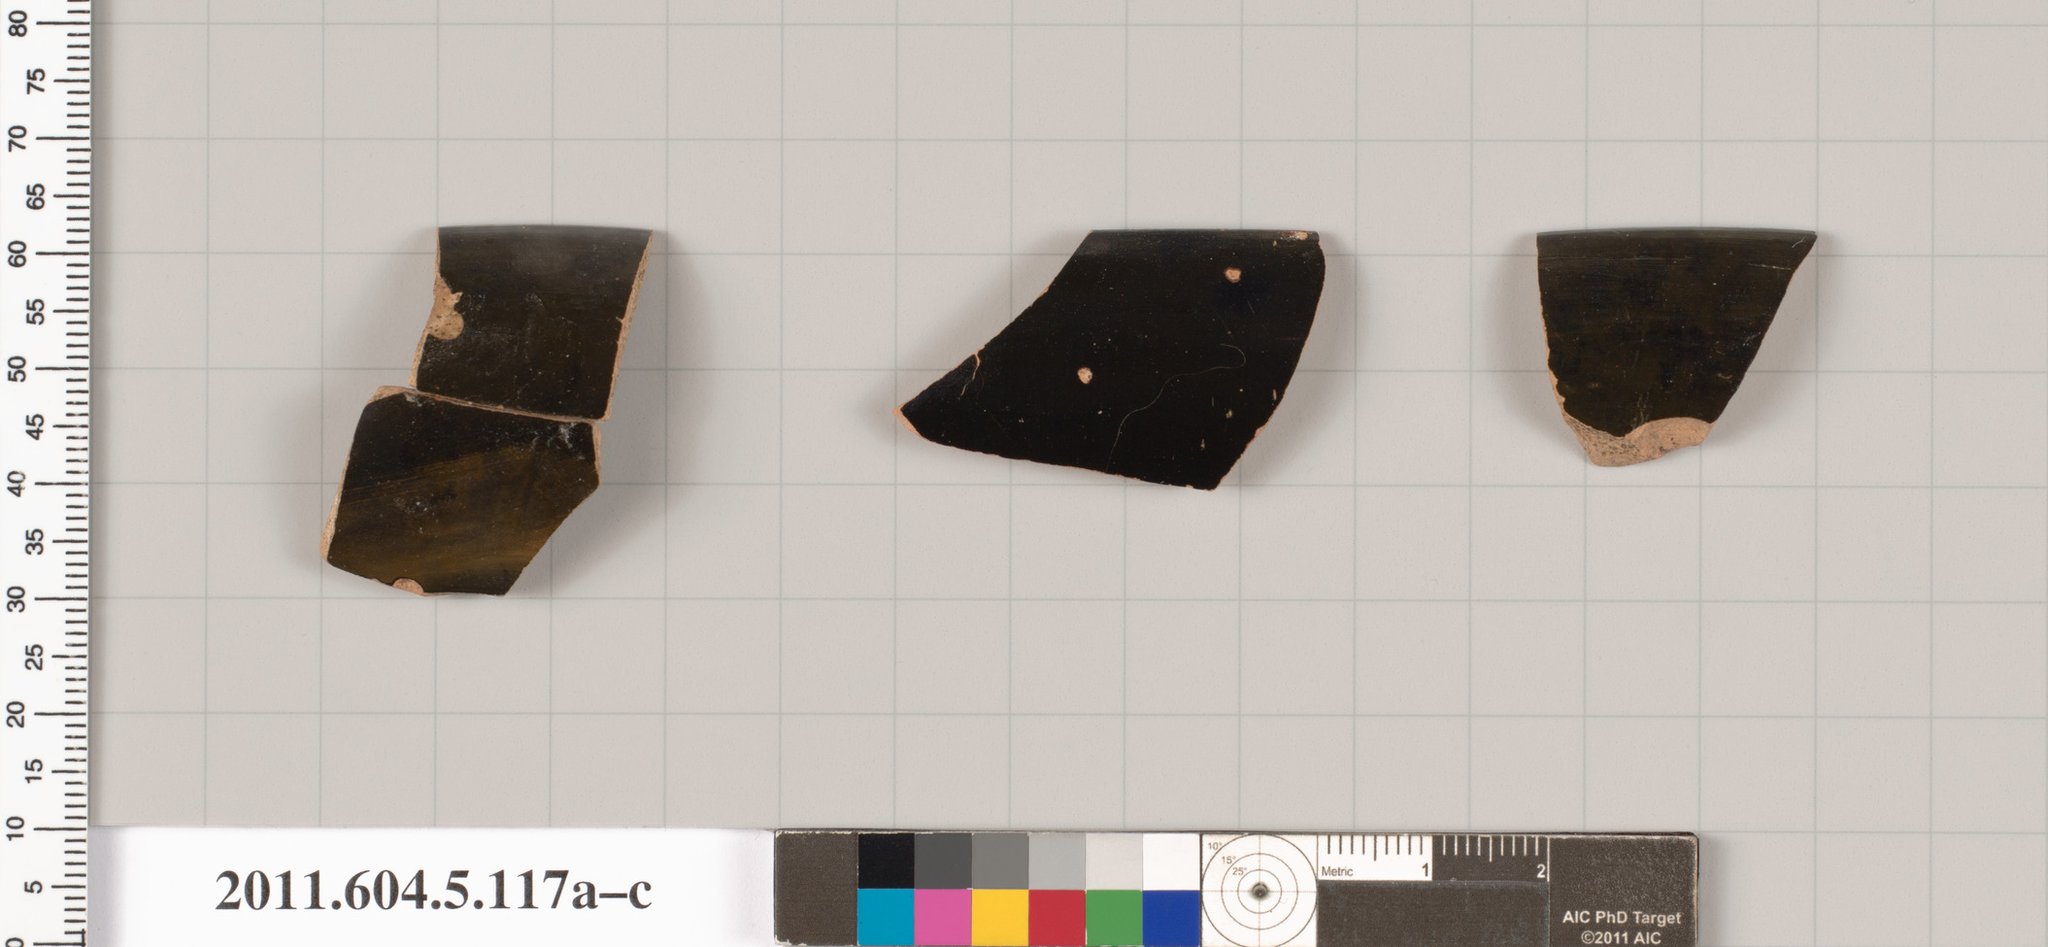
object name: kylix fragment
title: Terracotta rim fragments of stemless kylikes (drinking cups)?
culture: greek, attic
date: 470-450 BCE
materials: terracotta